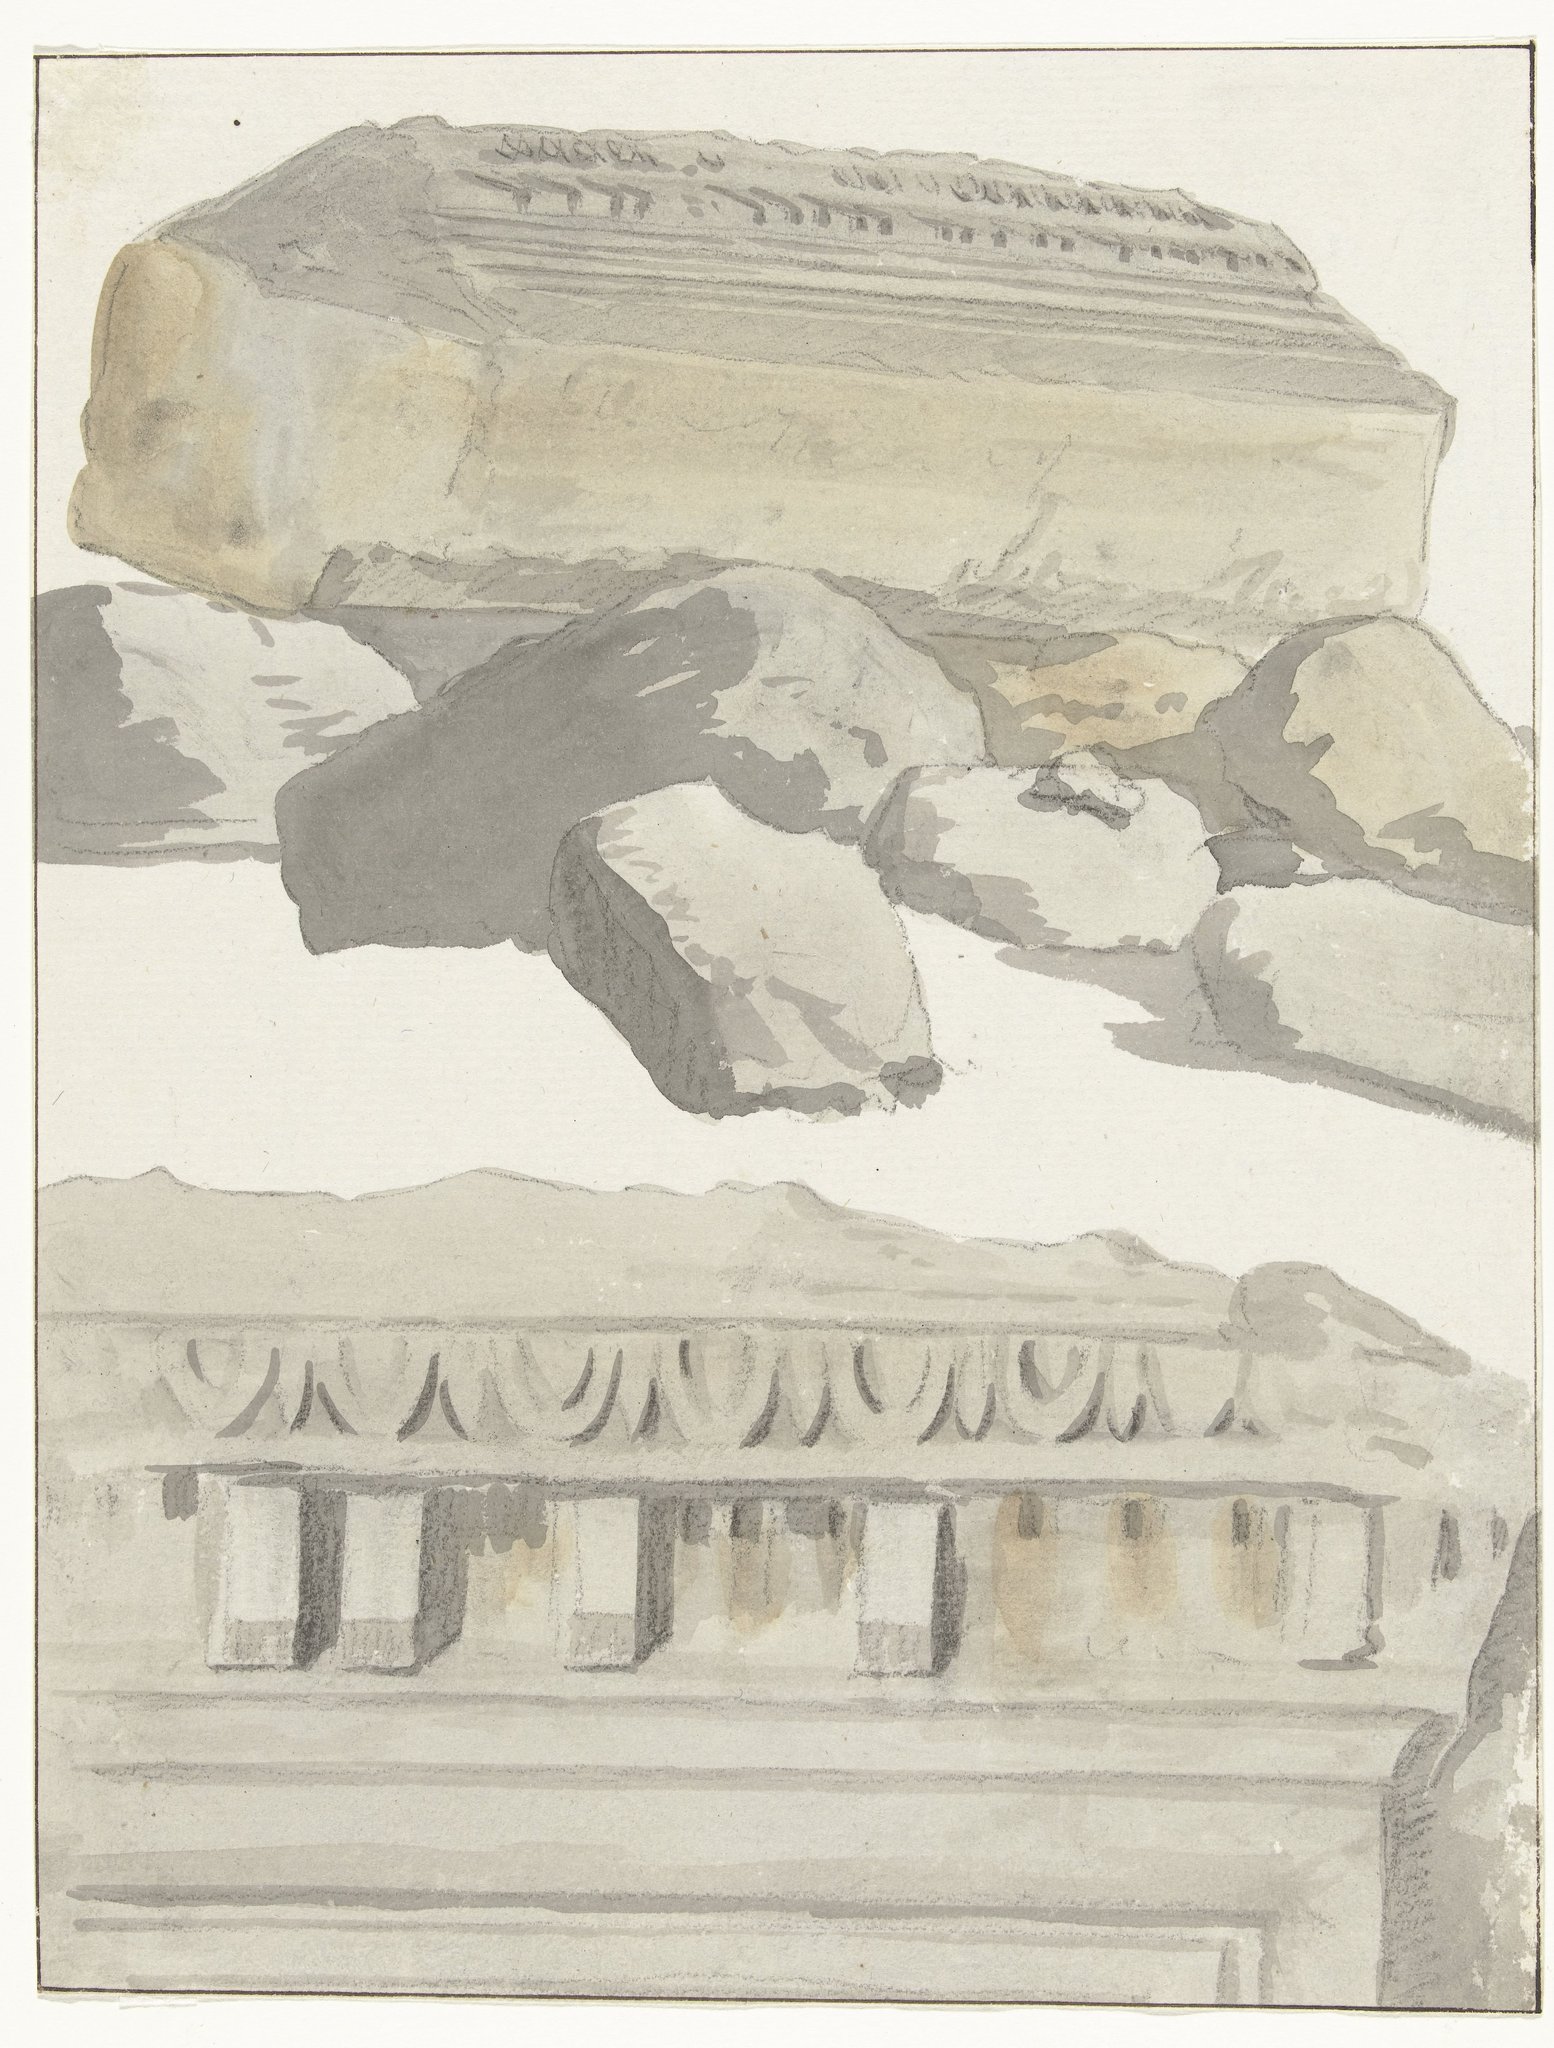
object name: drawing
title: Voyage en Italie, en Sicile et à Malte - 1778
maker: louis ducros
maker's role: draughtsman, print maker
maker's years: 1748-1810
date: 1778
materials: chalk, paper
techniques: brush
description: Tekening uit het album 'Voyage en Italie, en Sicile et à Malte', 1778.